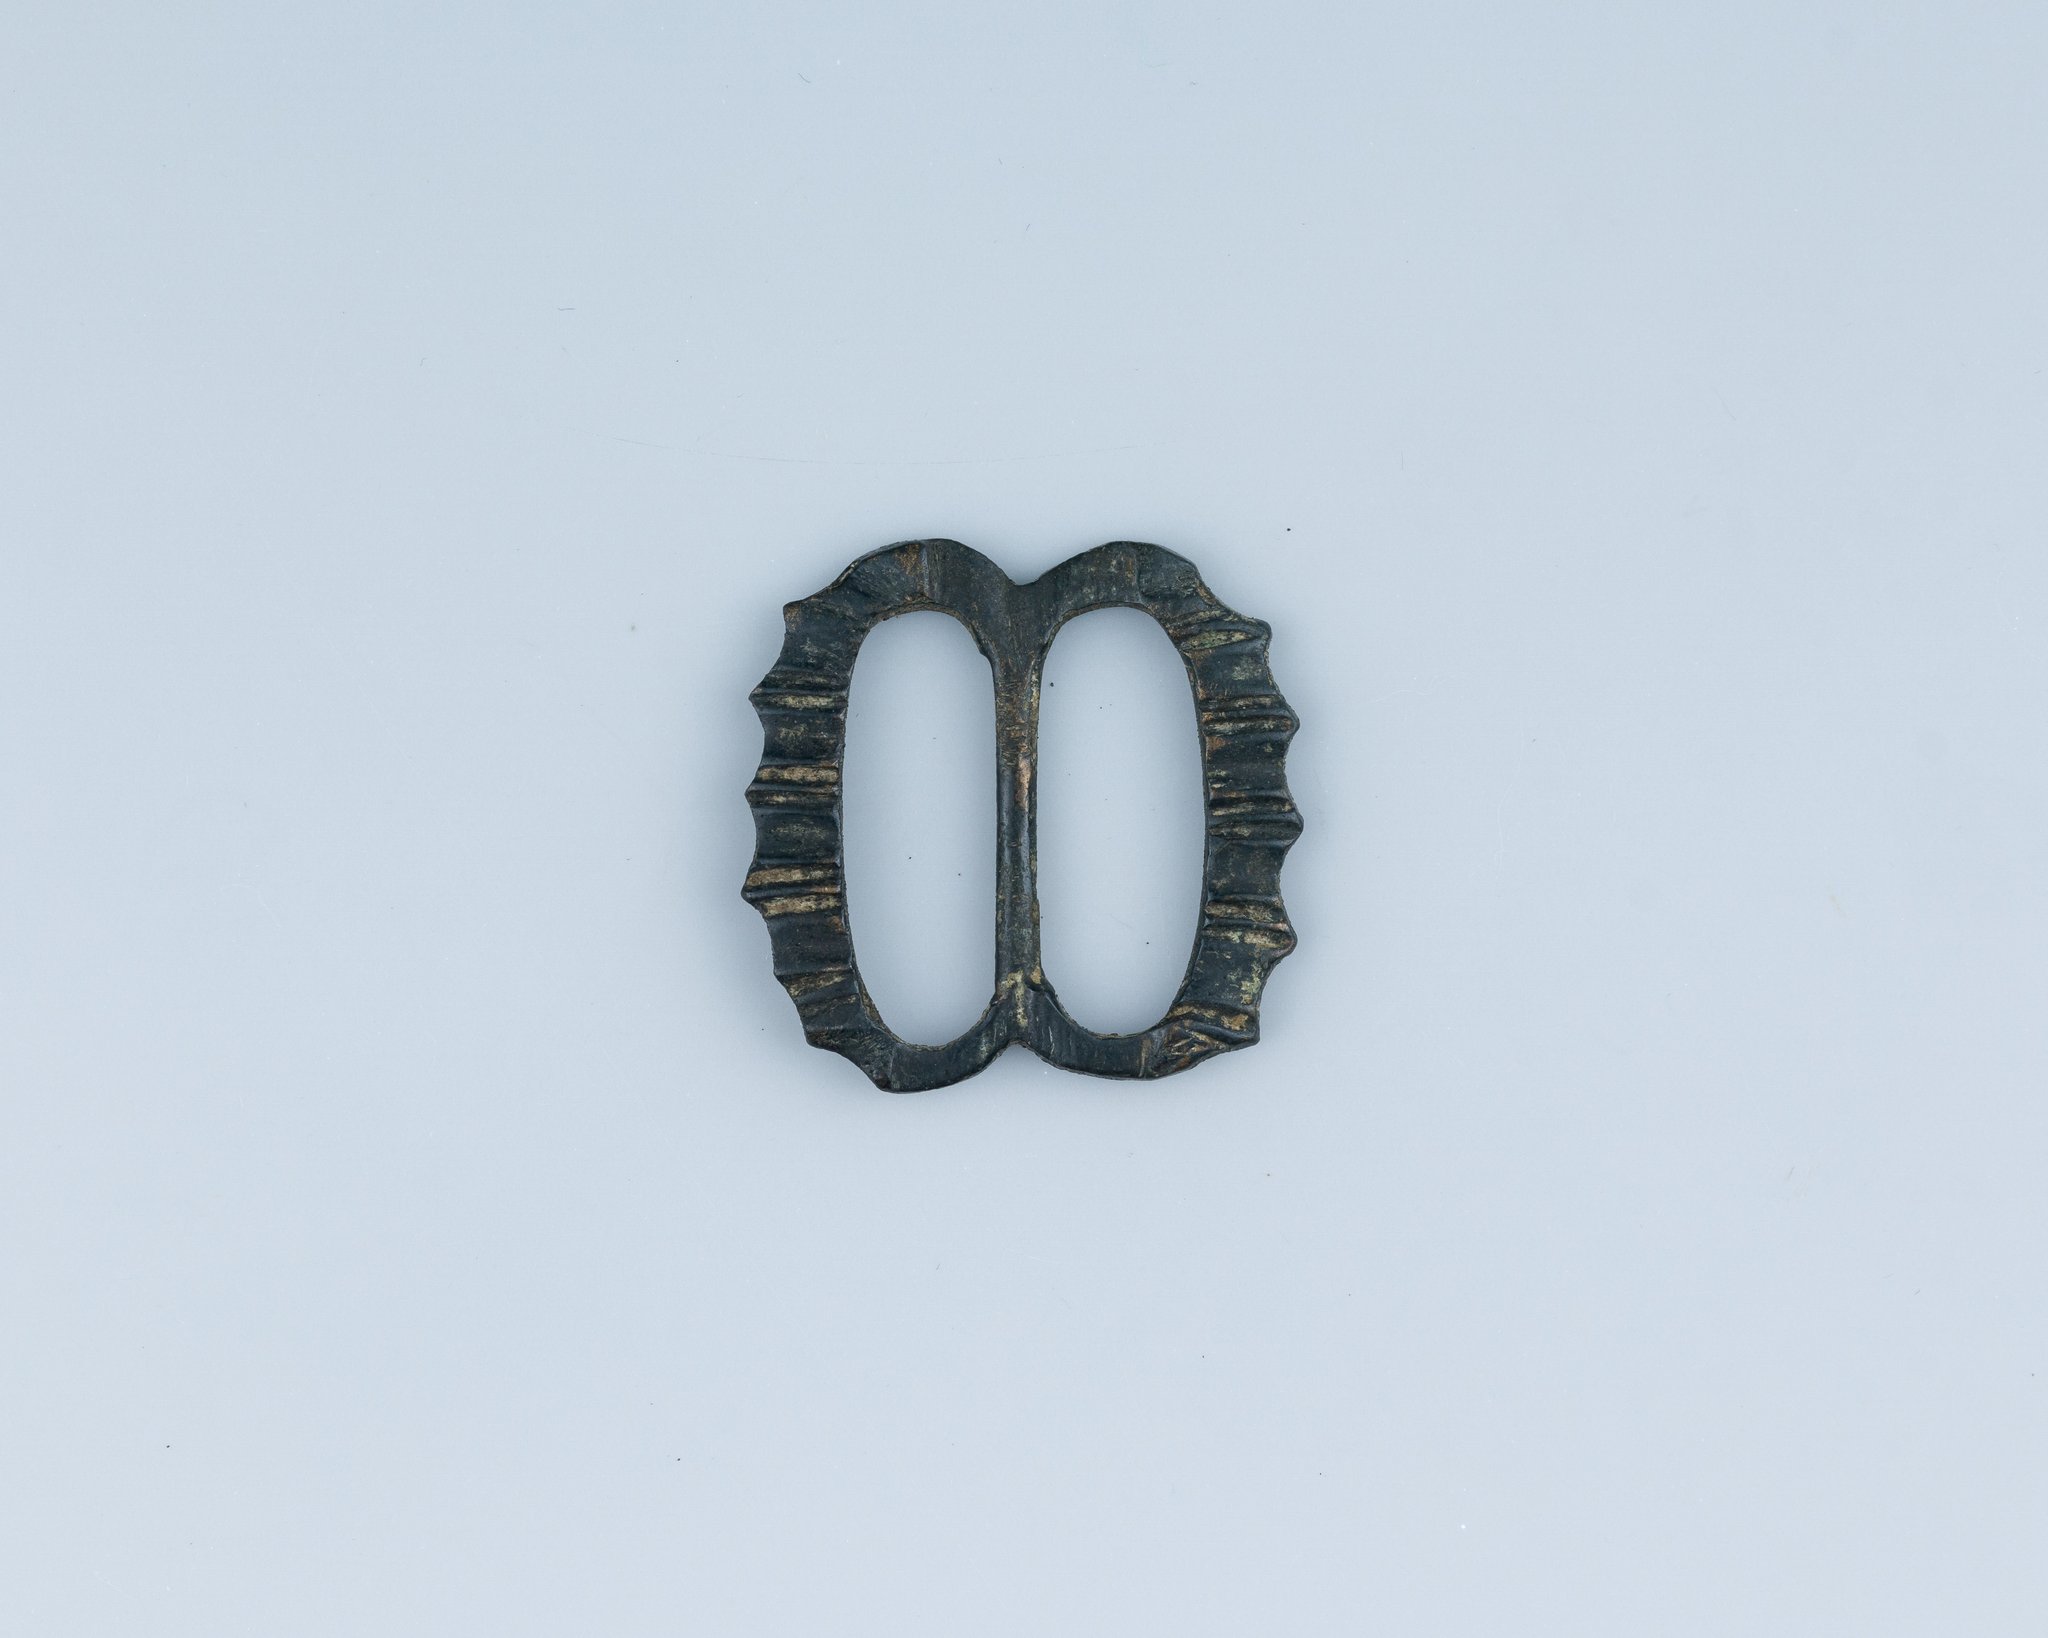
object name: buckle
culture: european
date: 1401-1600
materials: bronze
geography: germany